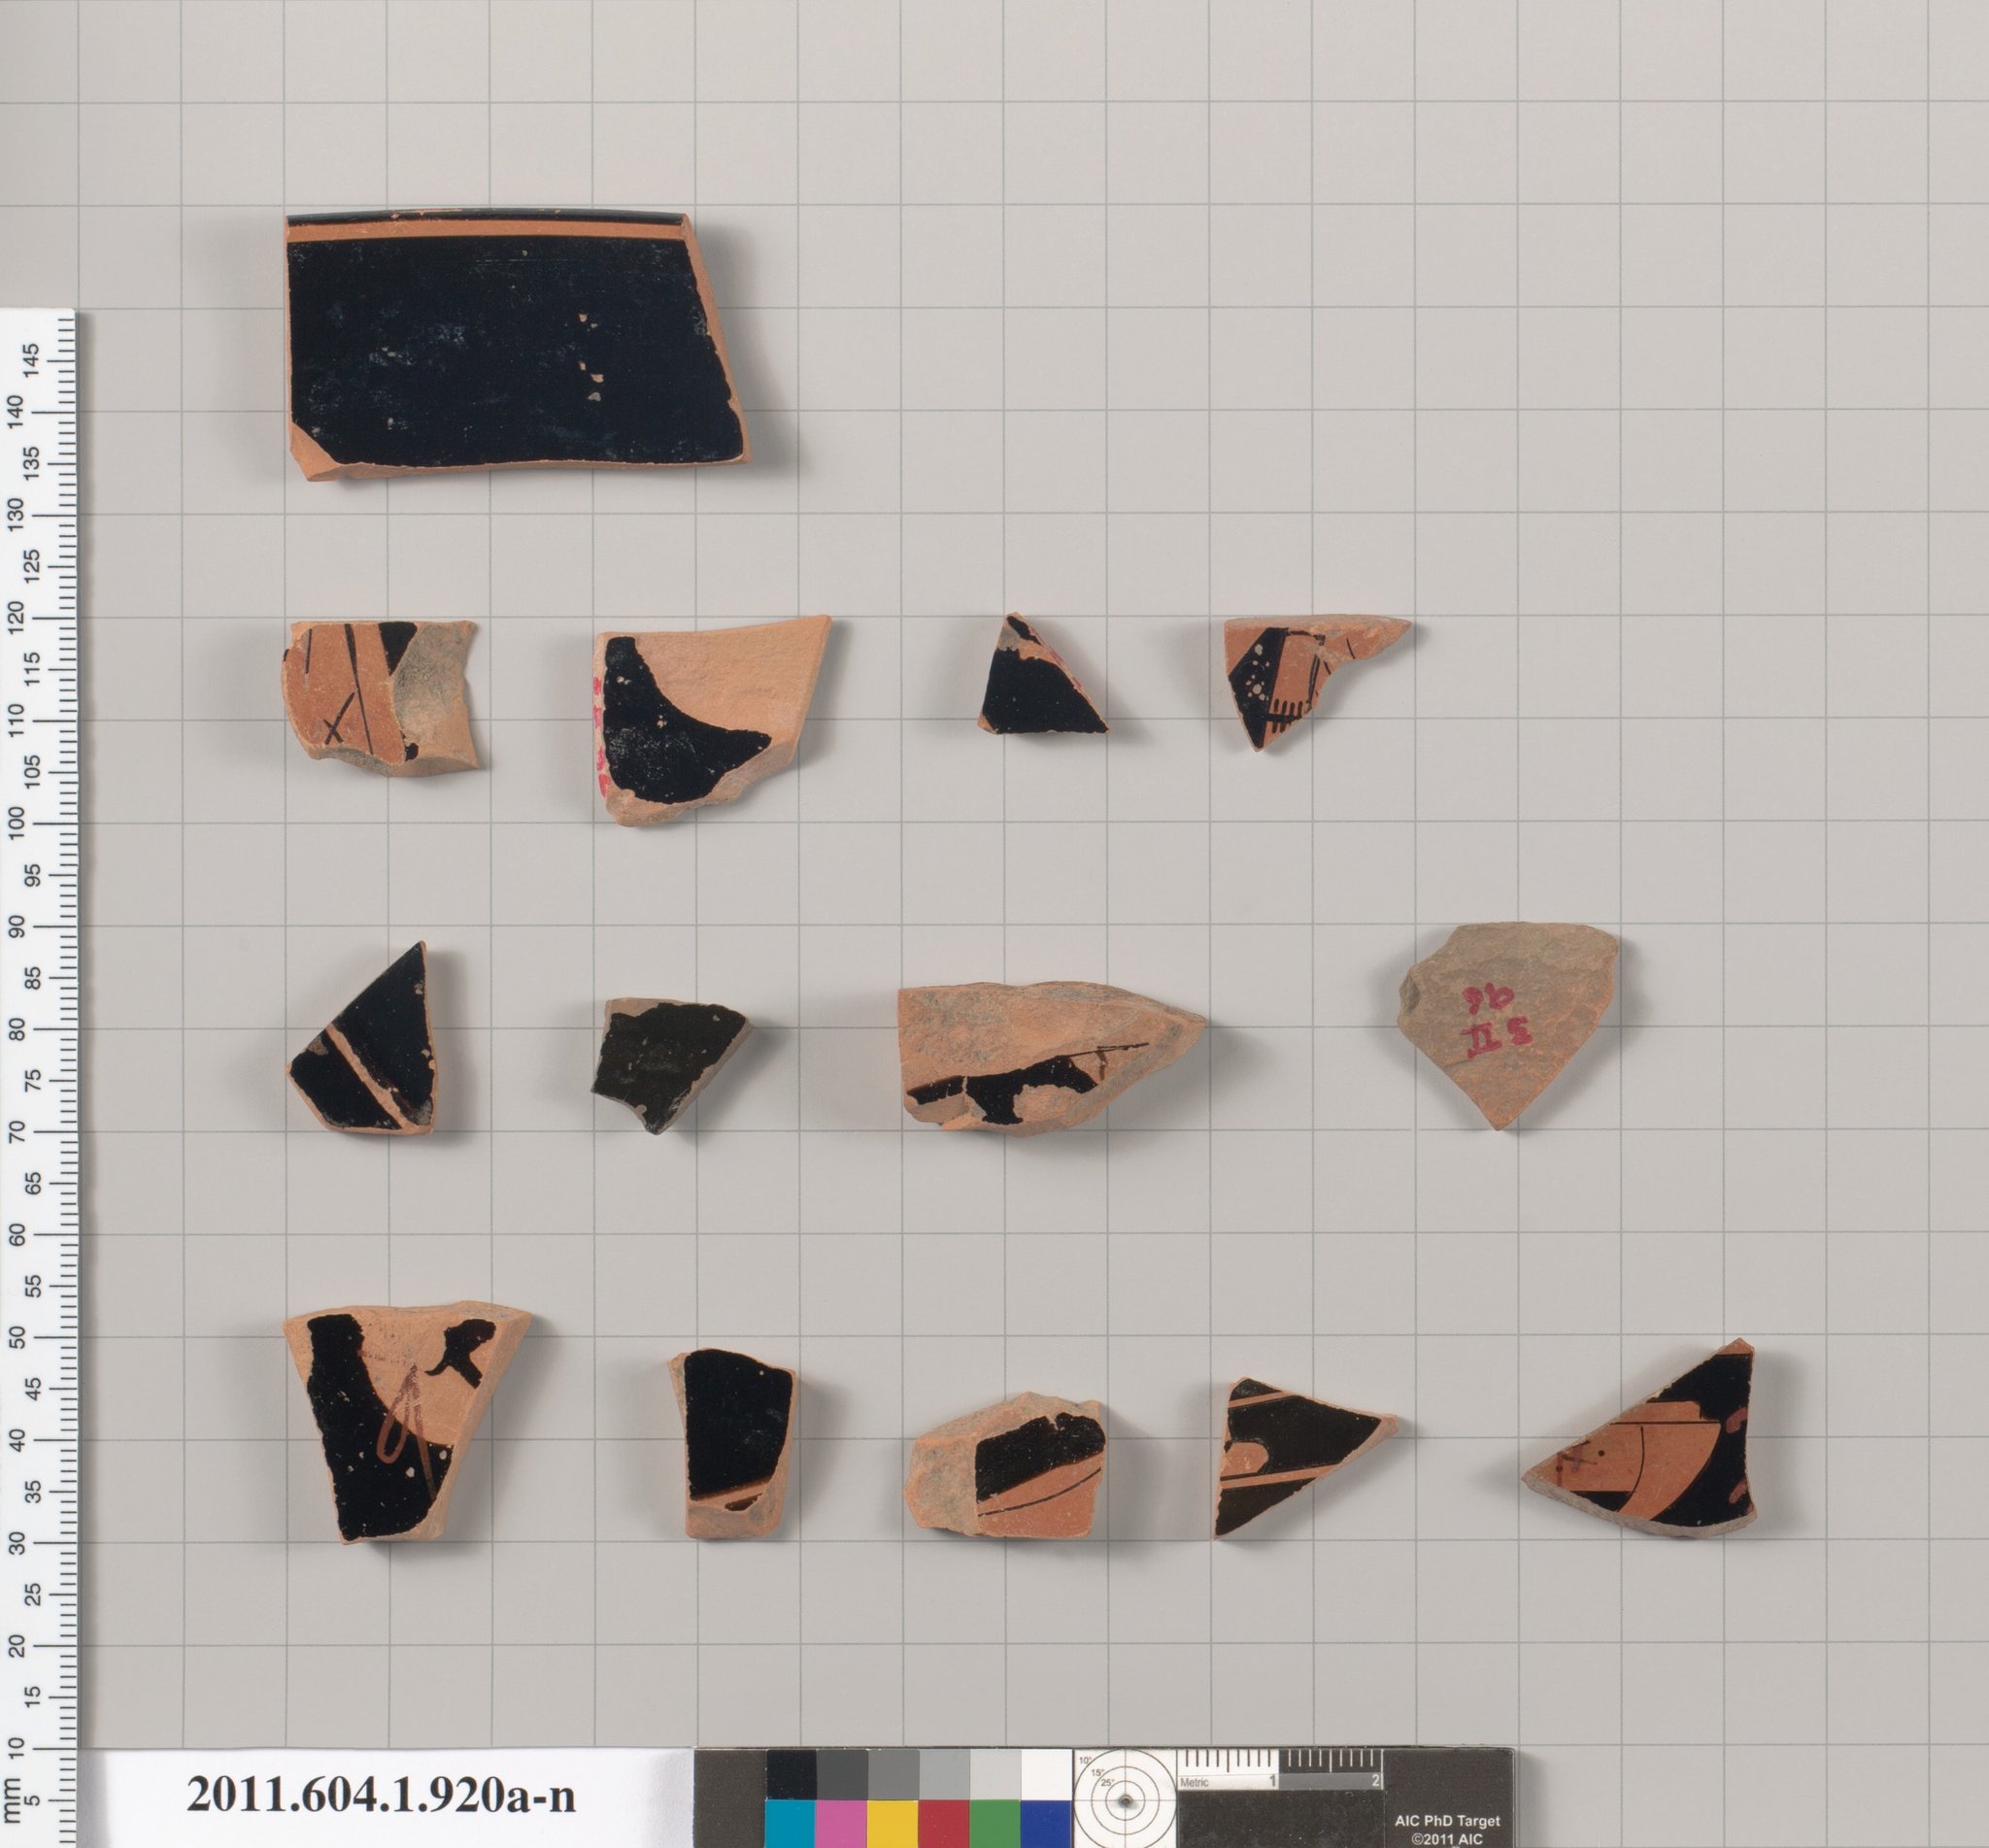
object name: kylix fragment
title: Terracotta fragments of kylikes (drinking cups)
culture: greek, attic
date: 500-401 BCE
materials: terracotta